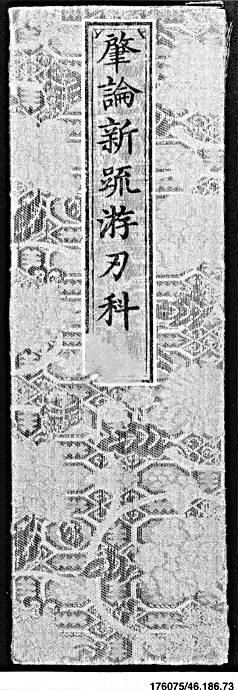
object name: sutra cover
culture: chinese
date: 1667-1733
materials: metal thread, silk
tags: flowers